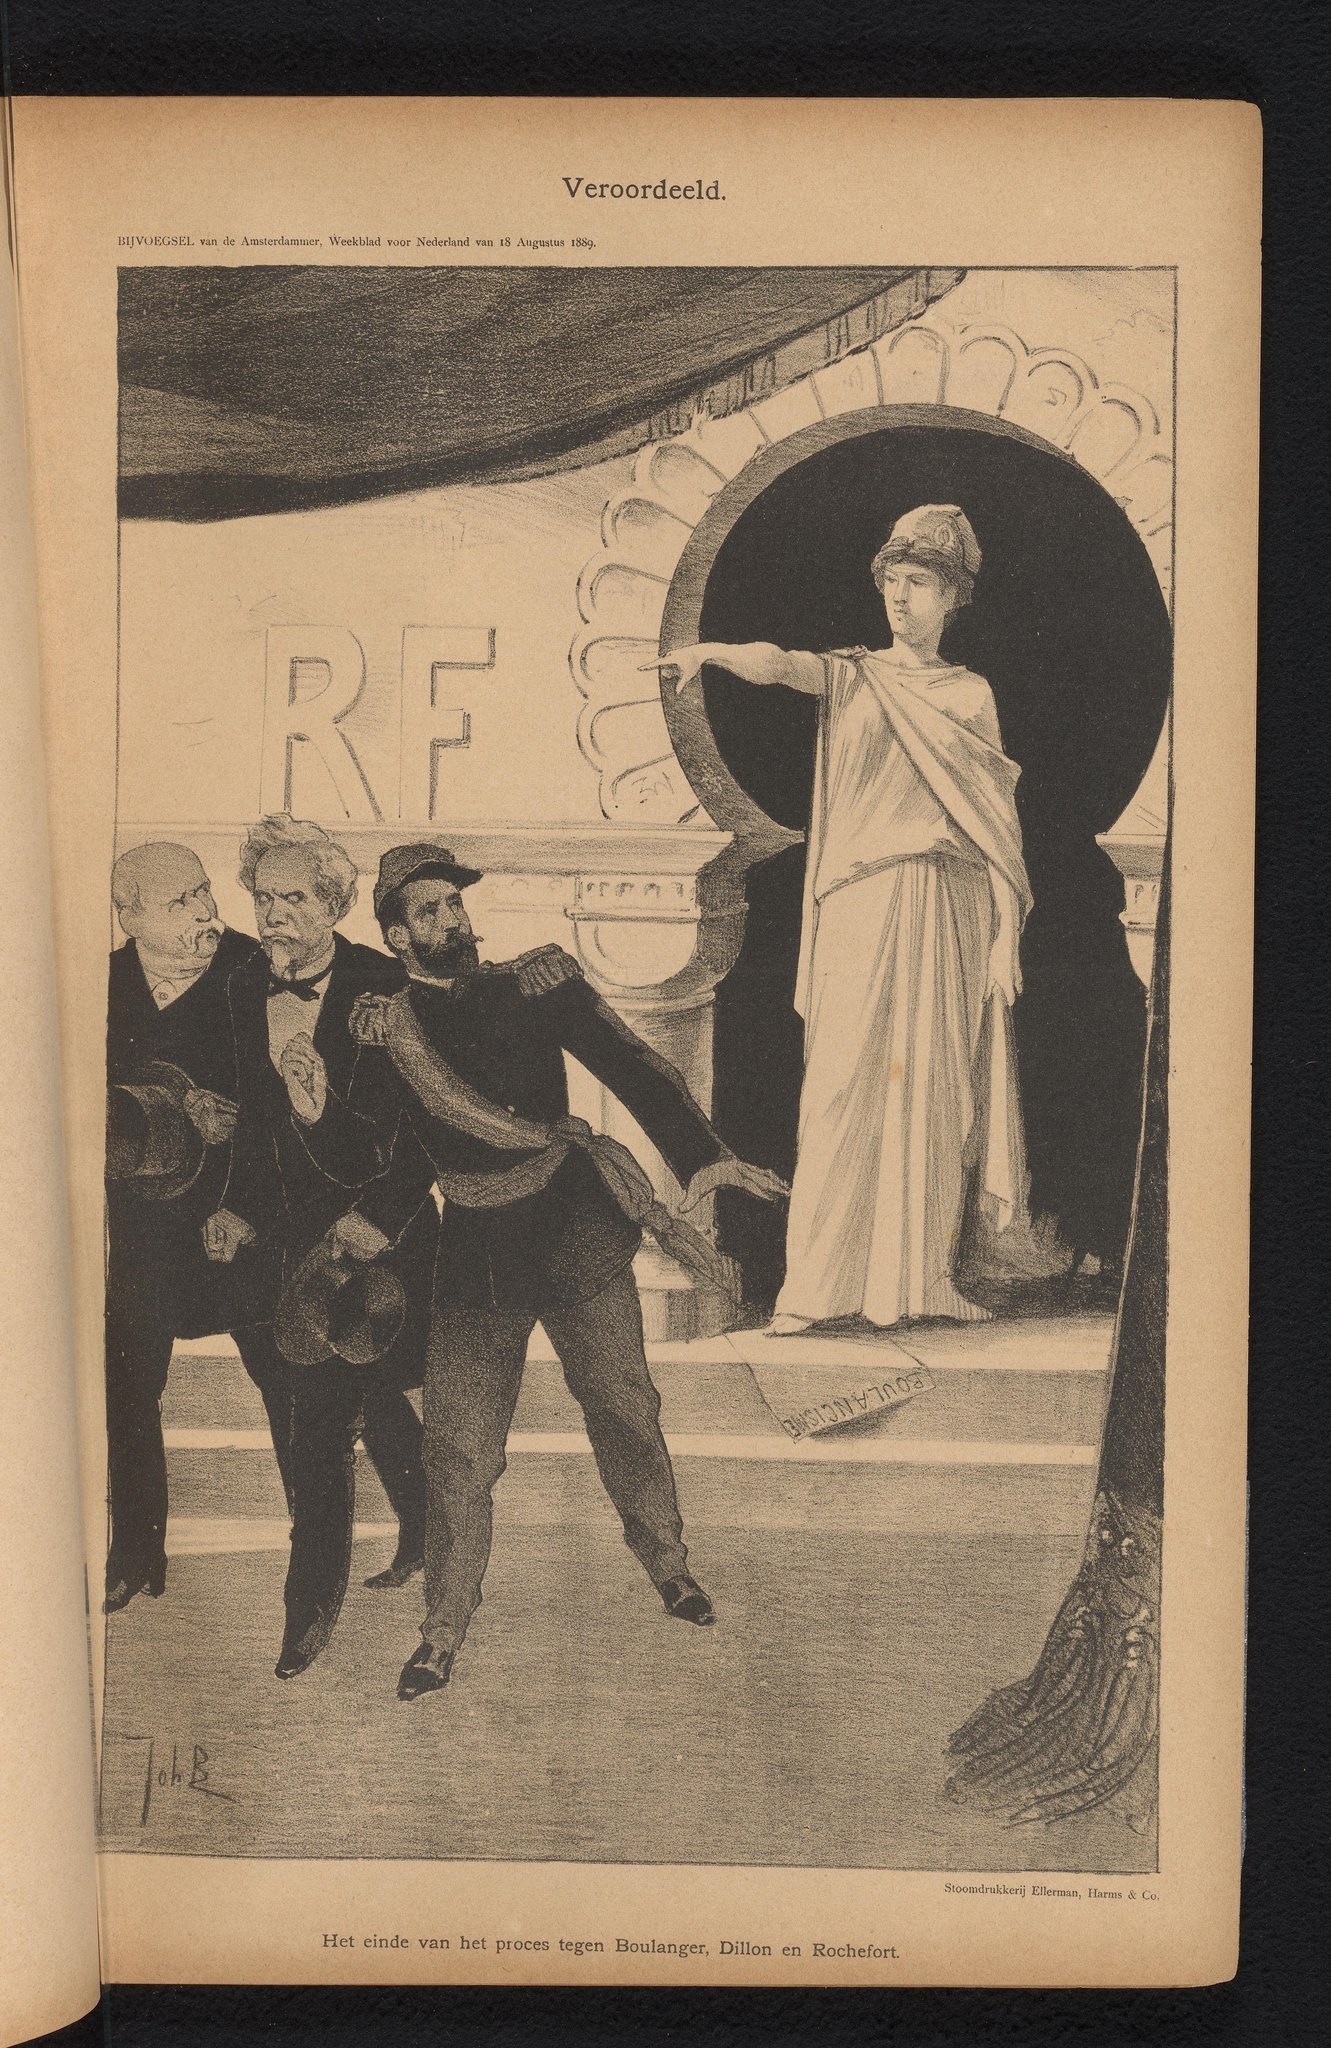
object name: cartoon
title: Veroordeeld / Het einde van het proces tegen Boulanger, Dillon en Rochefort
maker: johan braakensiek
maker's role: draughtsman, print maker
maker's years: 1858-1940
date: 1889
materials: paper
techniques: lithograph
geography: netherlands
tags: paris, judicial verdict, personifications of countries, nations, states, districts, etc. (+ nation; national), treason, political caricatures and satires, france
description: Marianne (Franrijk) stuurt Georges Boulanger, Dillon en Rochefort weg na de gerechtelijke uitspraak op 14 augustus waarin zij schuldig worden gevonden aan samenzwering tegen de staat.